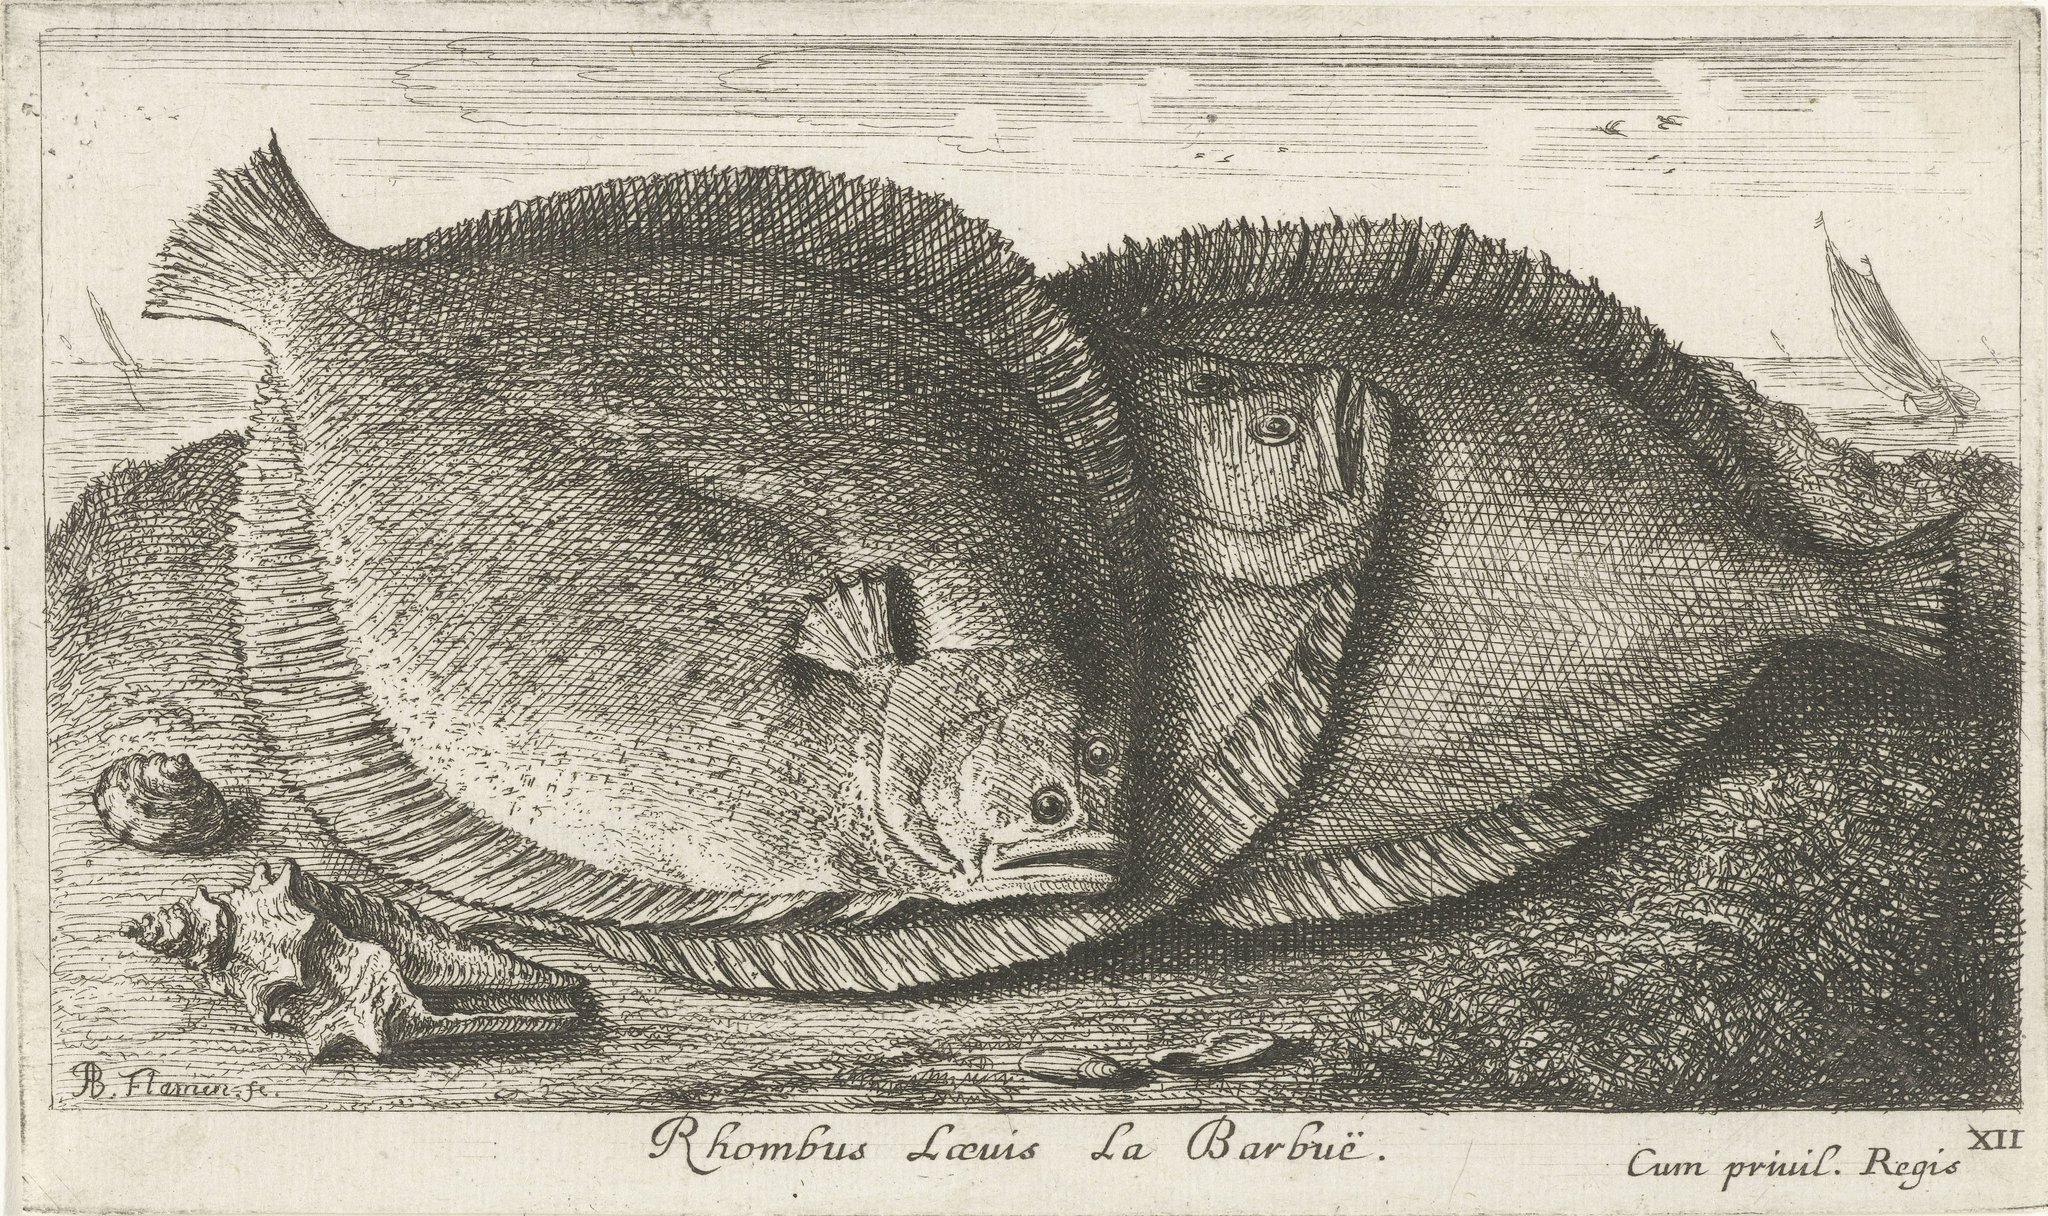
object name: print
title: Rhombus Laeuis La Barbuë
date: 1664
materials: paper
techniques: etching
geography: france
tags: fishes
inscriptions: collector's mark: Lugt 2228